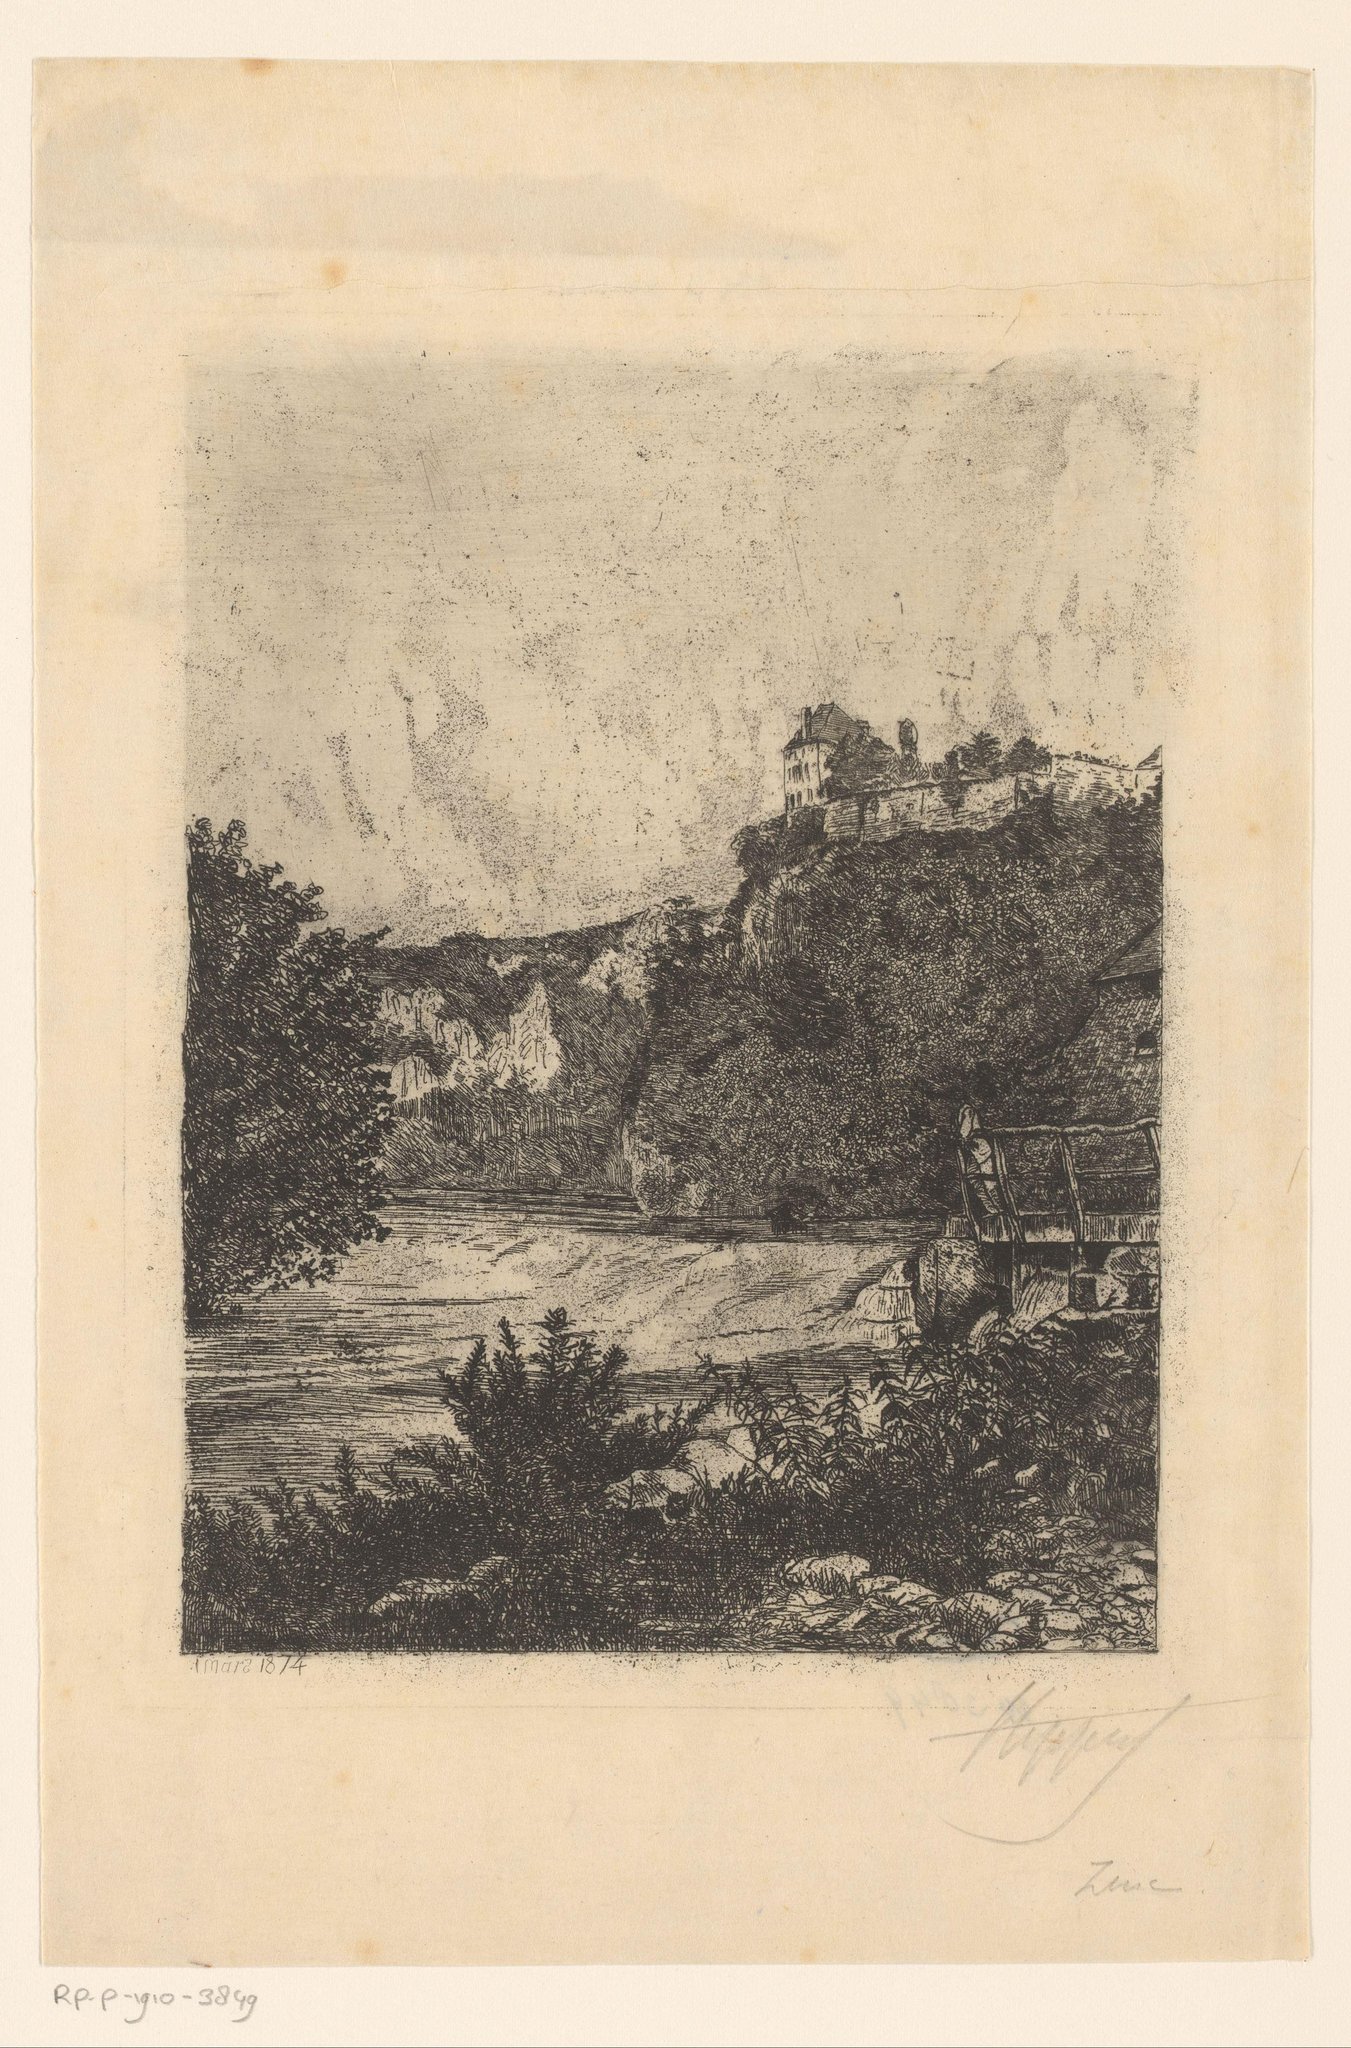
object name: print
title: Berglandschap met waterval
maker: karel theodoor hippert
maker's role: print maker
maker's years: 1839-1919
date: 1874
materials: paper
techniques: etching, intaglio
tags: castle, waterfall, (high) hill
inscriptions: collector's mark: Lugt 2228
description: Op de heuvel op de achtergrond staat aan burcht. Op de voorgrond een figuur bij een reling die naar de waterval kijkt.